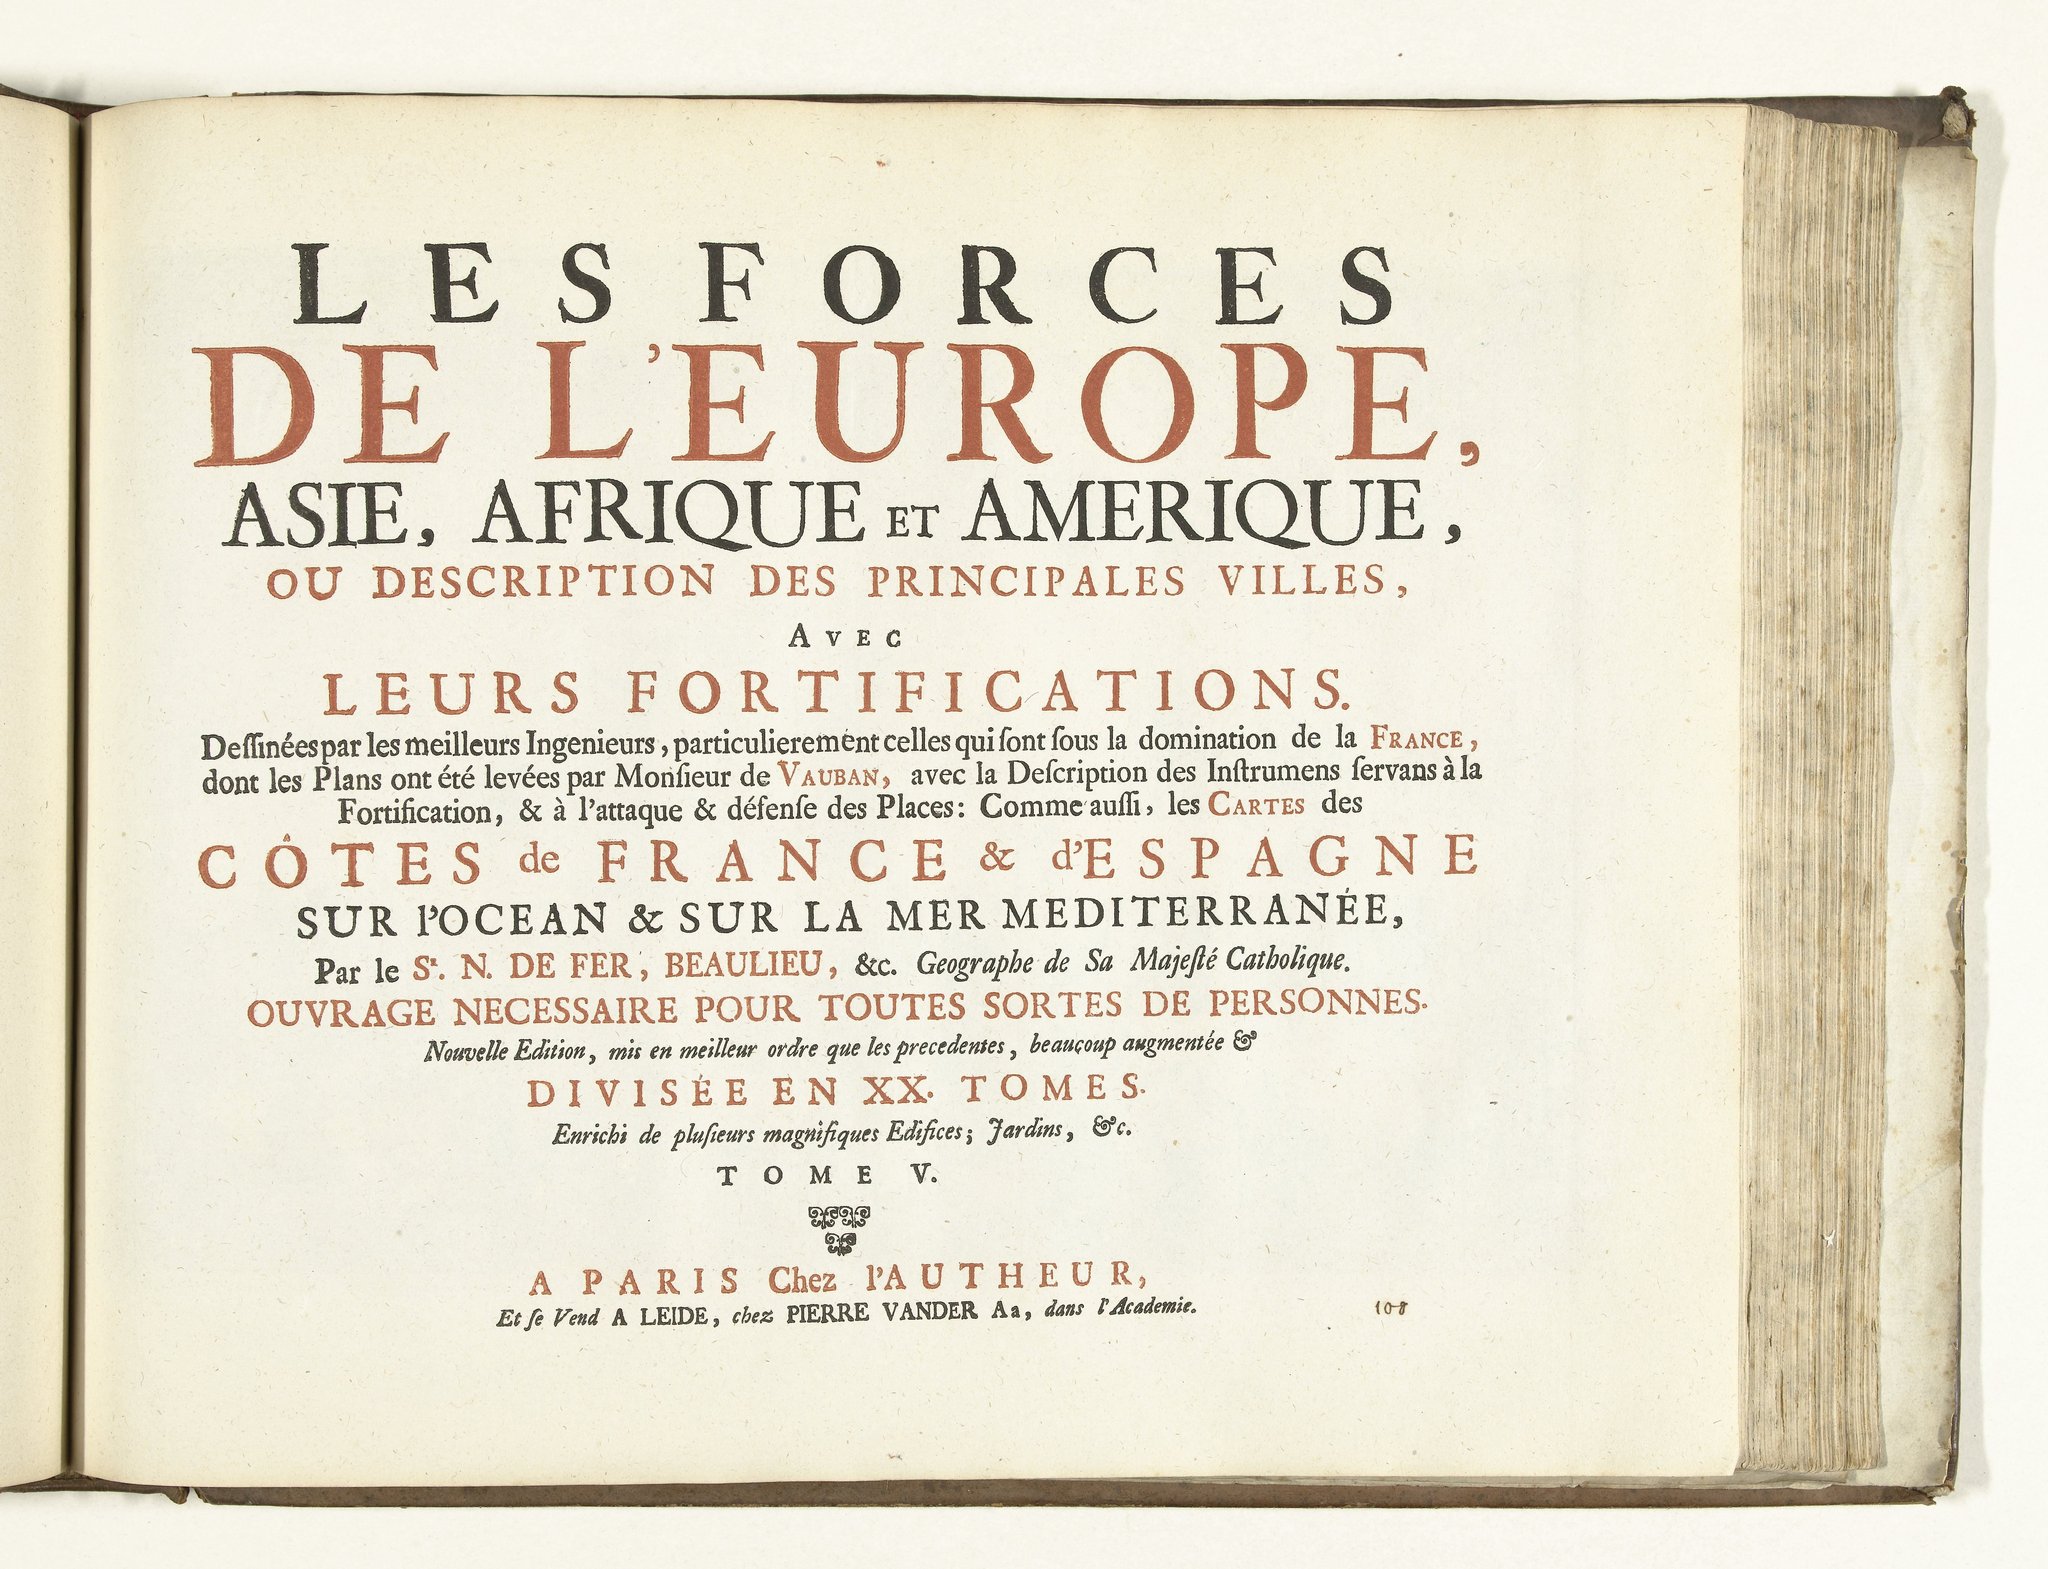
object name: titelblad, titelpagina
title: Titelpagina voor het prentwerk: Les Forces de l'Europe, Asie, Afrique et Amerique (...) Comme aussi les Cartes des Côtes de France et d'Espagne (deel V), 1726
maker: pieter van der aa (i)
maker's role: printer, publisher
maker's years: 1659-1733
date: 1726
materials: paper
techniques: letterpress printing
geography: leiden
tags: spaanse successieoorlog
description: Titelpagina gedrukt in zwart en rood voor deel V van het prentwerk Les Forces de l'Europe, Asie, Afrique et Amerique ... Comme aussi les Cartes des Côtes de France et d'Espagne, 1726. Dit eerste deel van het prentwerk bestaat uit 238 met de hand genummerde platen van vermaarde sterke steden en vestingen in het kader van de Spaanse Successieoorlog 1701-1713. Voor het merendeel zijn deze platen gekopieerd naar de anonieme Franse platen van vermaarde sterke steden en vestingen: in Les forces de l'Europe en in: Le theatre de la guerre, dans les Pays-Bas, beide oorspronkelijk uitgegeven door Nicolas de Fer te Parijs (1693-1697) in het kader van de Negenjarige Oorlog. Titel in het Frans.